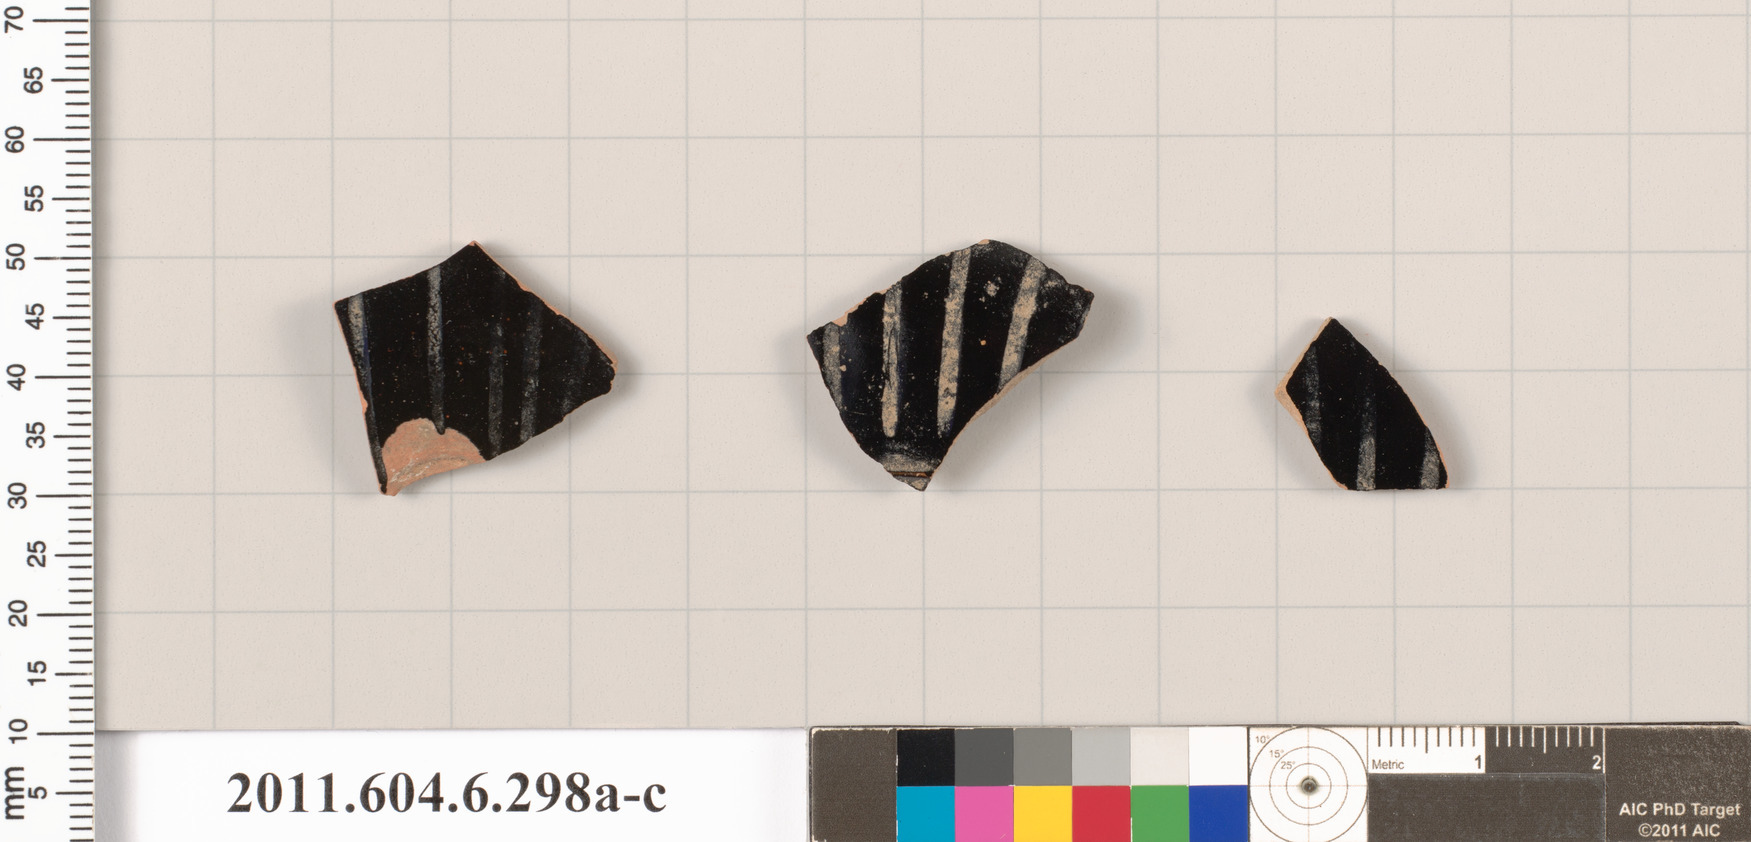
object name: undetermined open shape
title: Terracotta fragments of open shapes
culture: greek, attic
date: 400-301 BCE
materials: terracotta